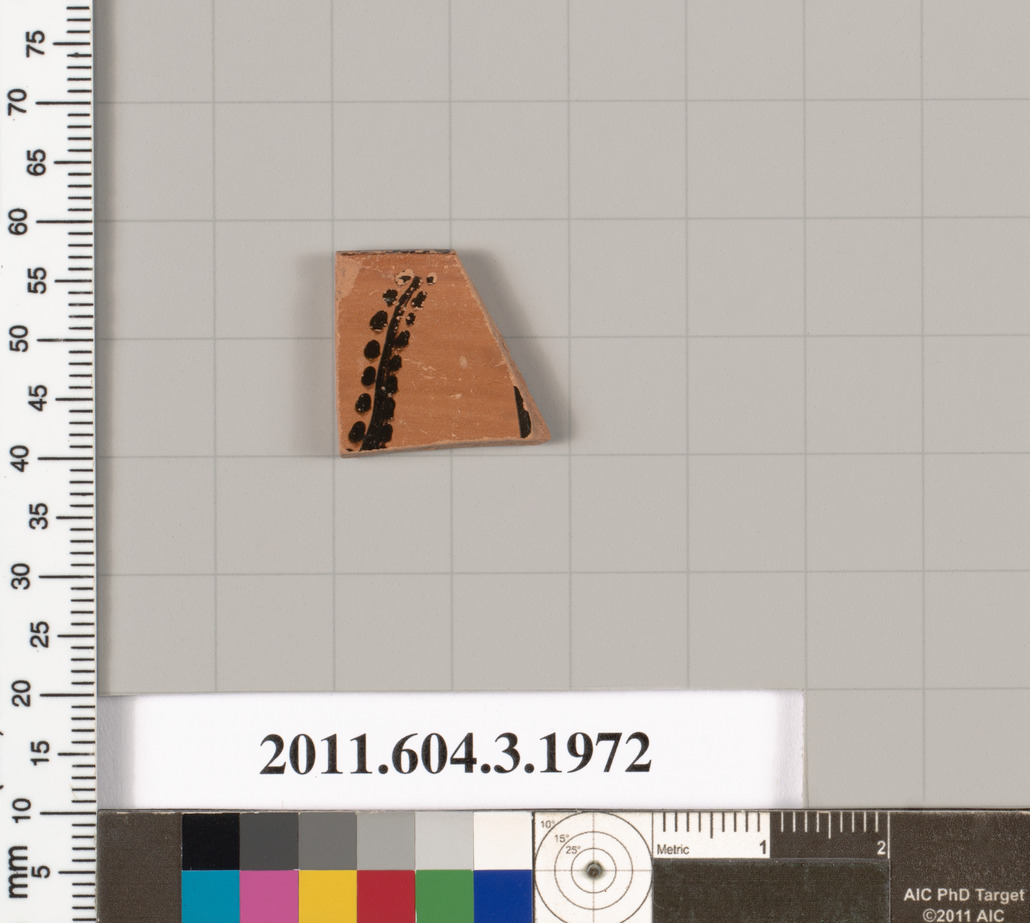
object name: kylix fragment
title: Terracotta fragment of a kylix (drinking cup)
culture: greek, attic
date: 550-526 BCE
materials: terracotta